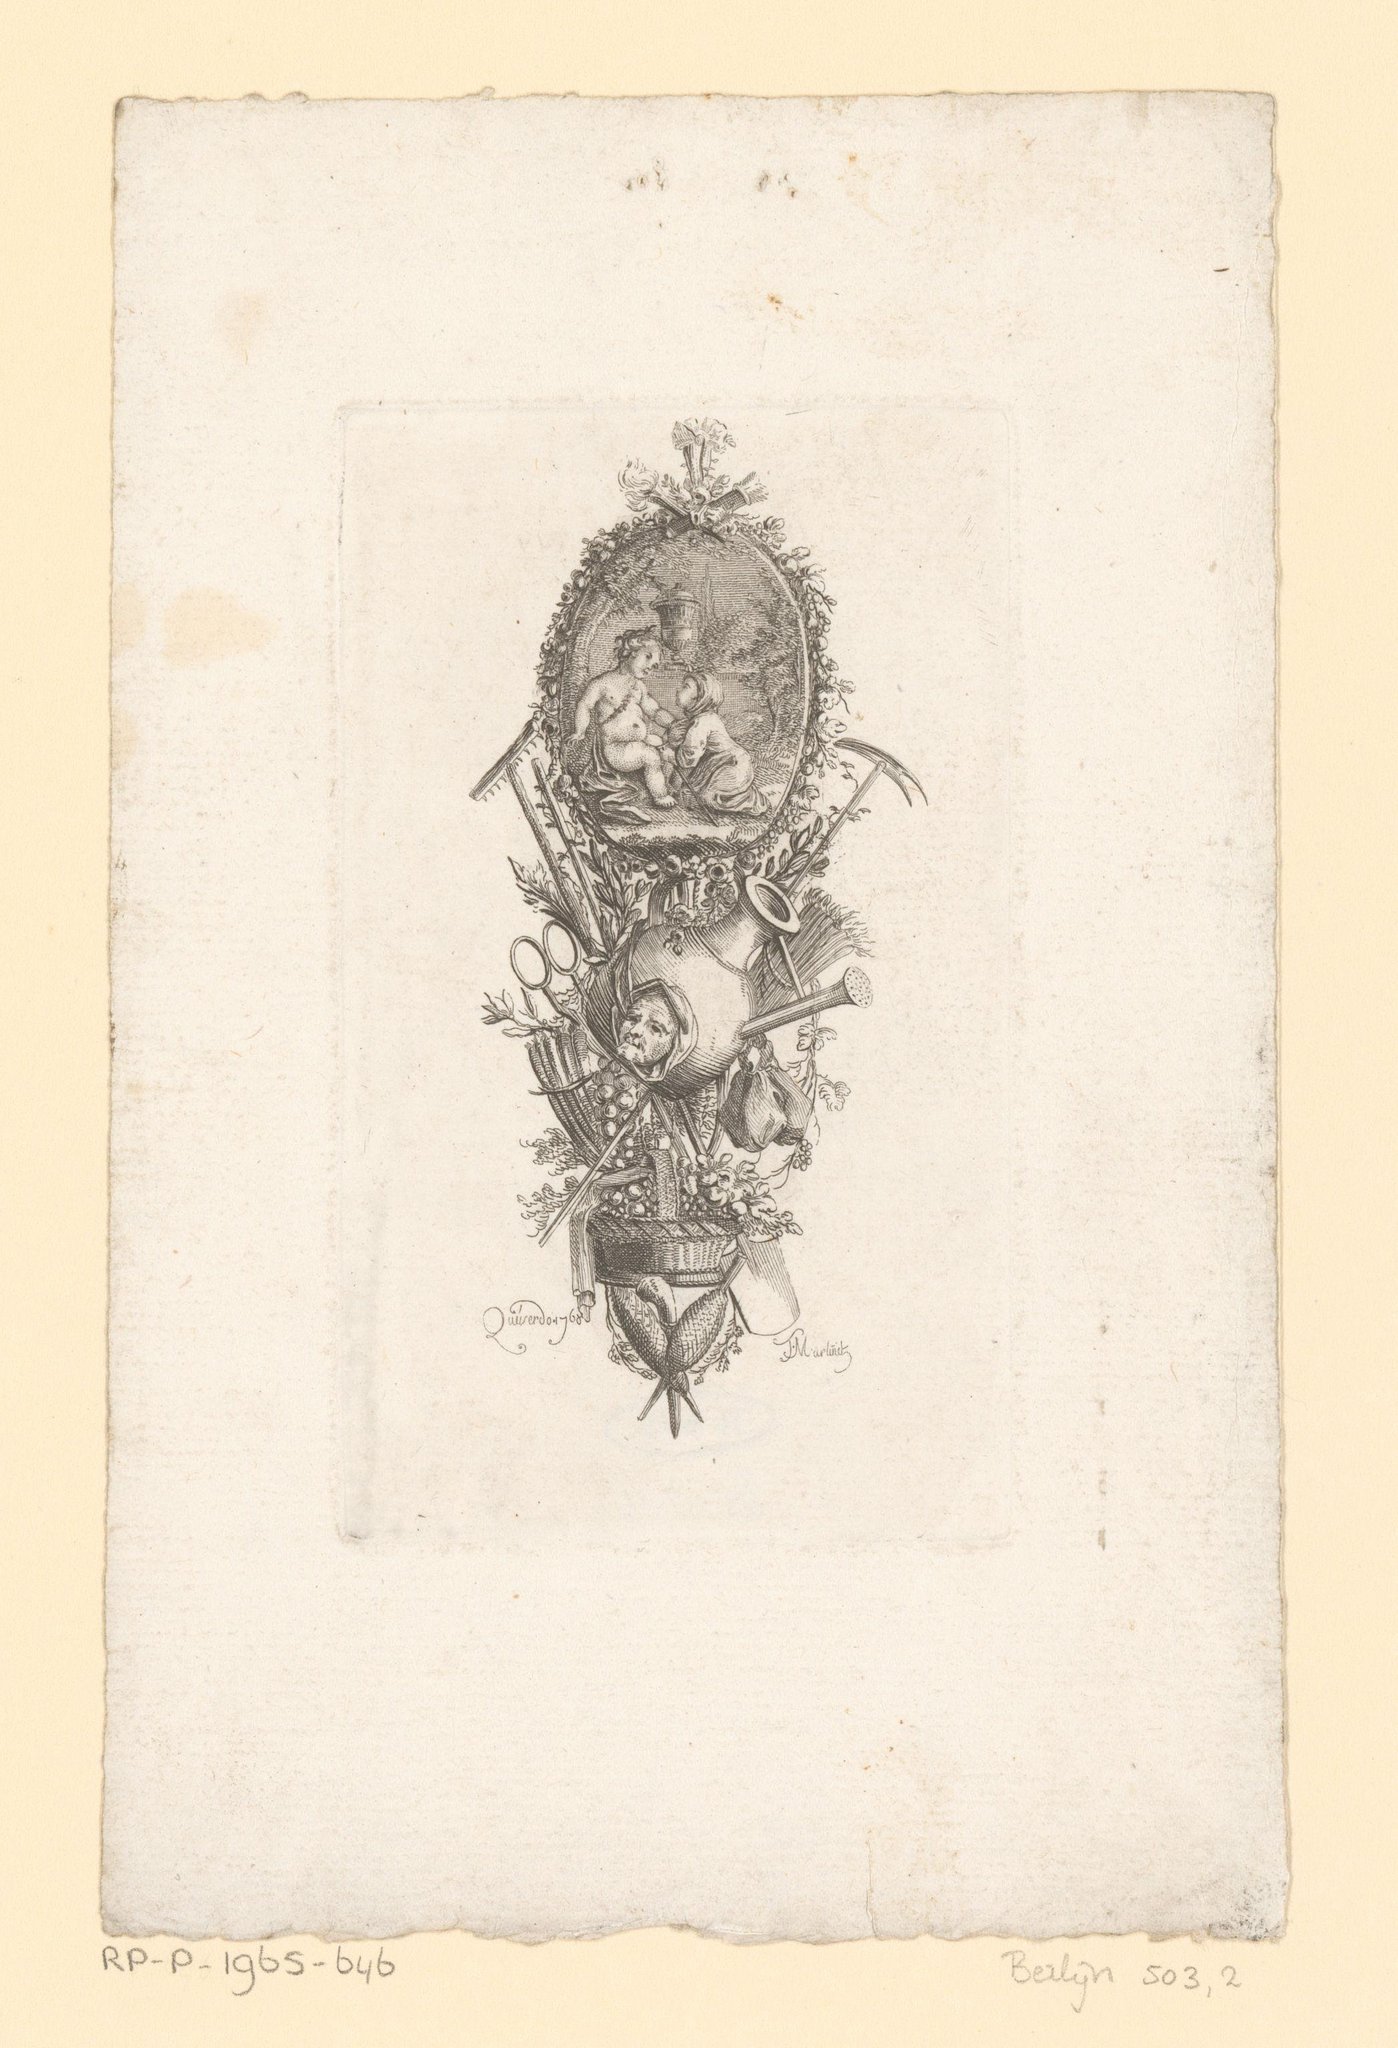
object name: print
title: Trofeeën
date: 1768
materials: paper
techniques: etching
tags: trophy, i.e.: decorative arrangement of symbolic or typical objects ~ ornament, agricultural implements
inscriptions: collector's mark: Lugt 2228, collector's mark: Lugt 2760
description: Een trofee met agrarische objecten zoals een hark, een gieter, een schep en een mand met fruit. Aan de bovenzijde een rond medaillon met twee putti.